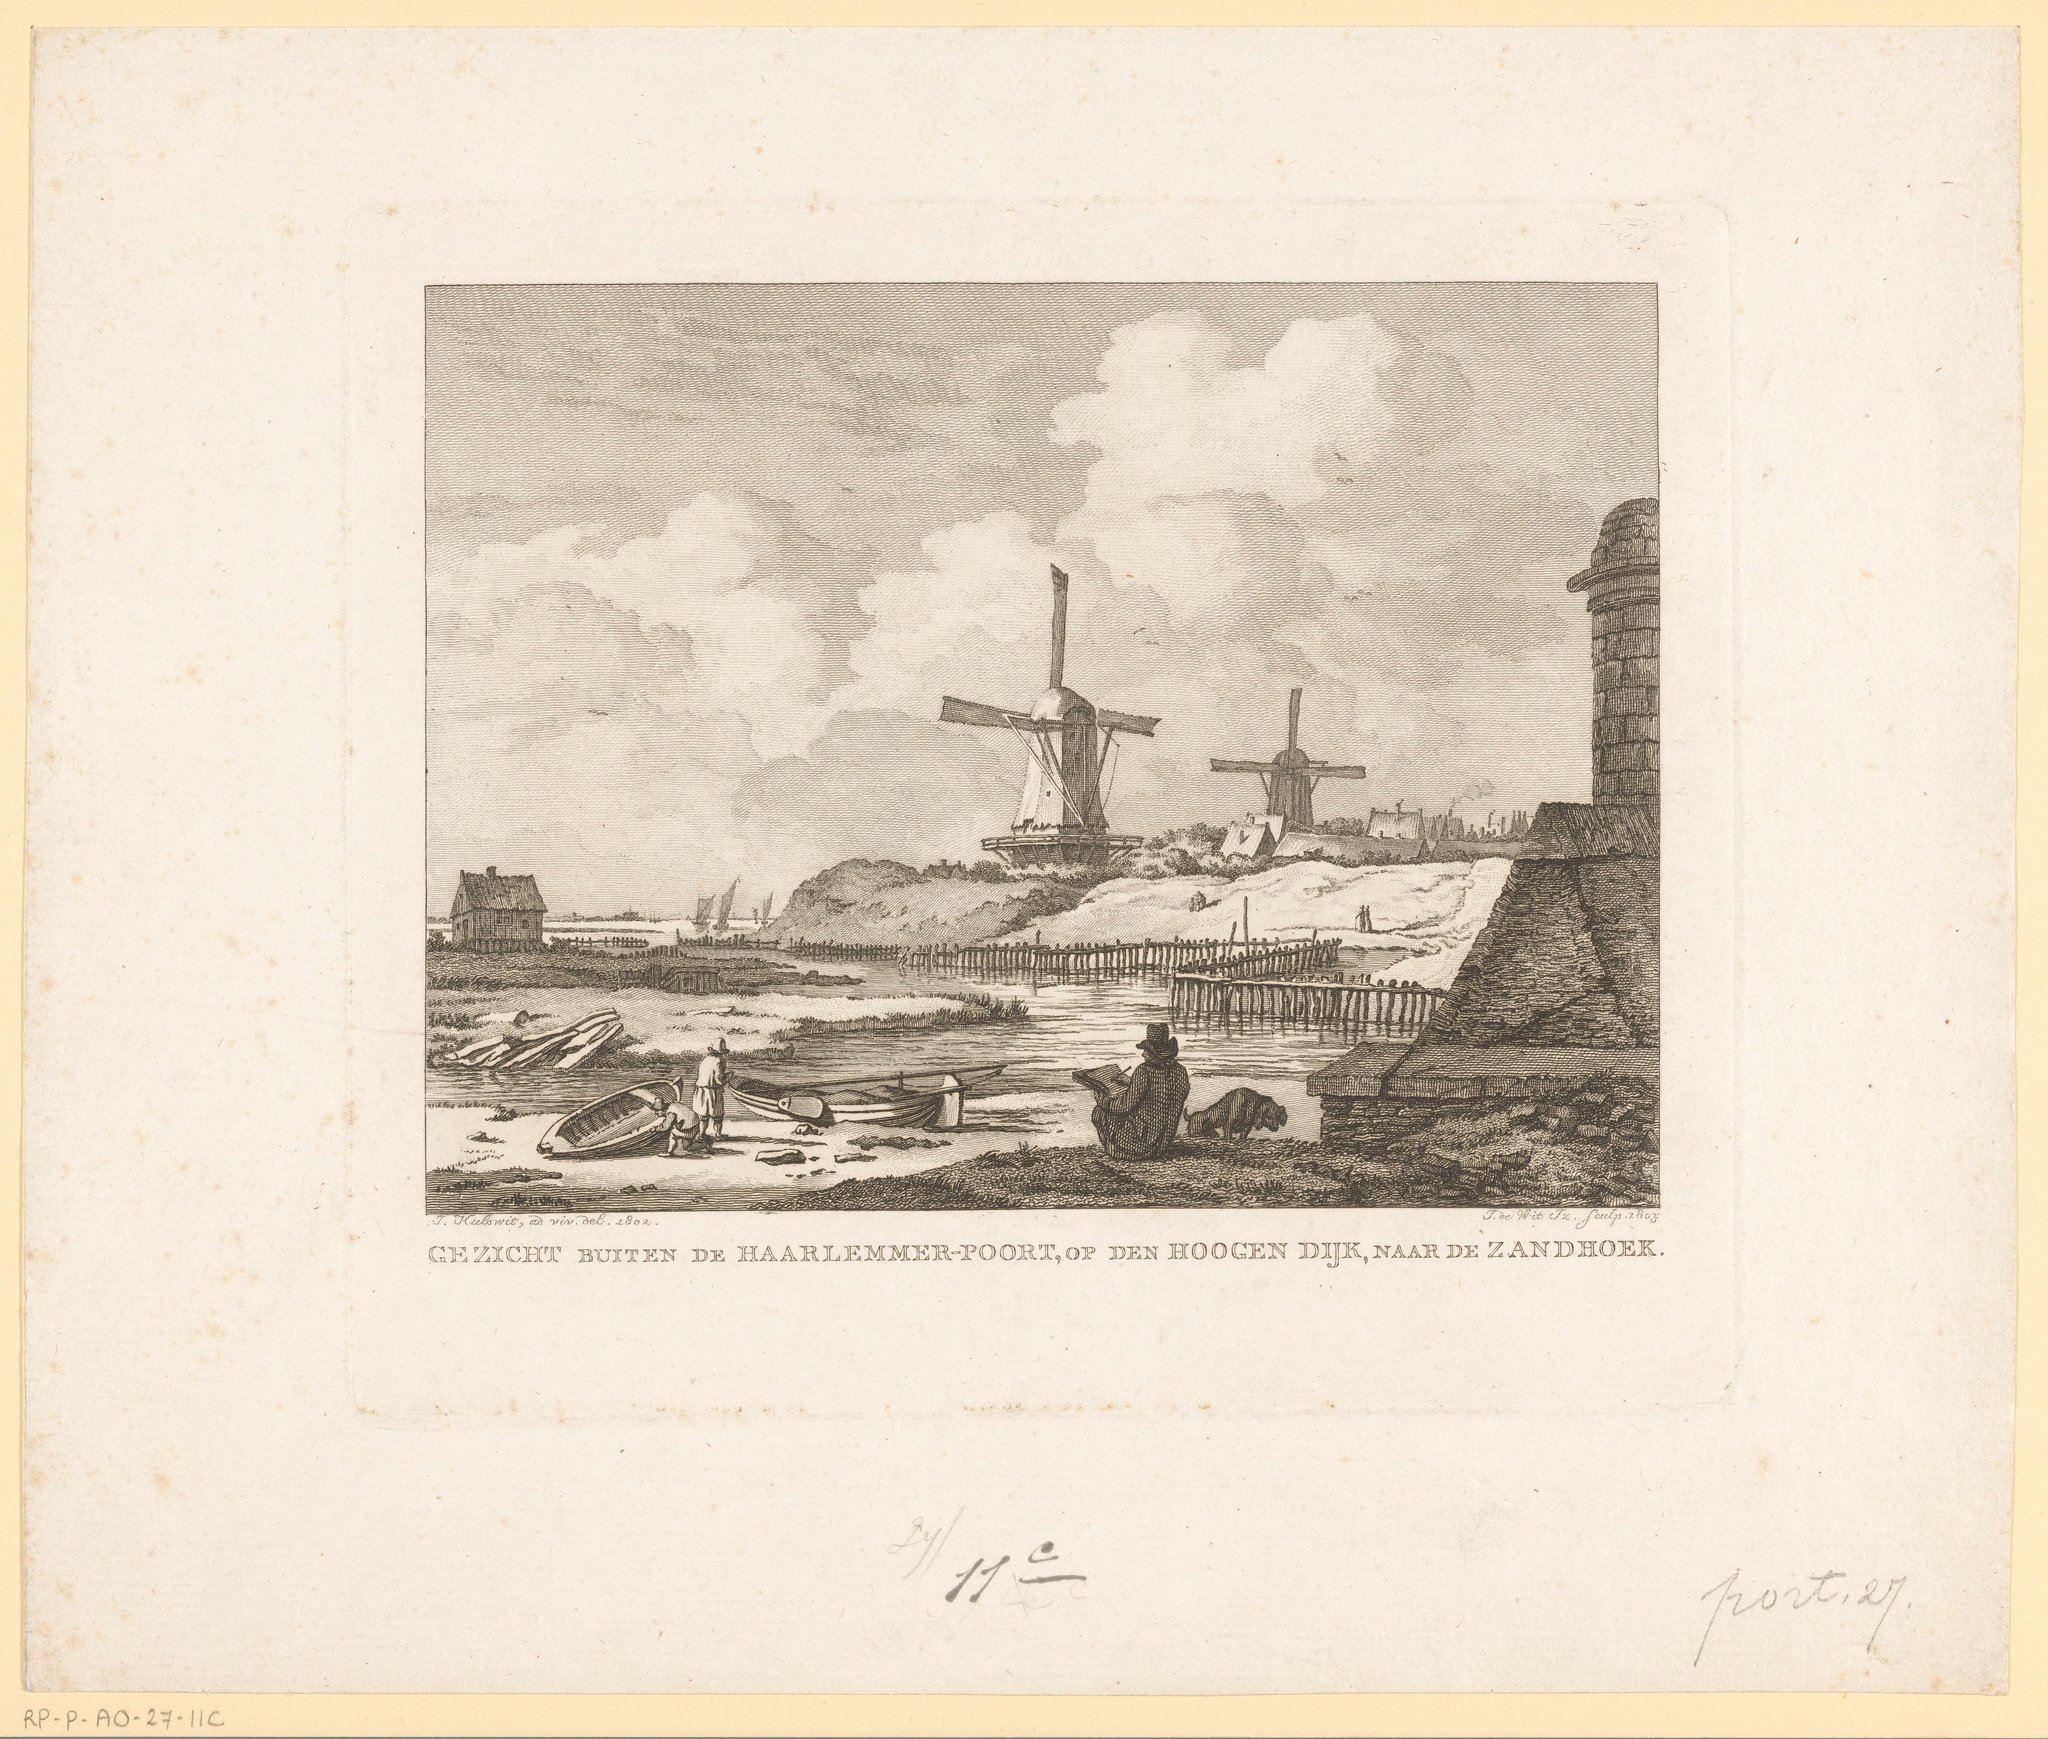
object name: print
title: Gezicht buiten de Haarlemmer-Poort, op den Hoogen Dijk, naar de Zandhoek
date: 1803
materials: paper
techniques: etching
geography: haarlem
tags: artist (in general) making preliminary designs, sketching - bb - out of doors (+ artist at work), windmill in landscape, repairing, caulking, careening (~ ship)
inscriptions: collector's mark: Lugt 2228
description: Een tekenaar met een hond zit bij een dijk met molens en huizen, buiten de Haarlemmerpoort te Amsterdam. Voor hem twee mannen die hun boten repareren.